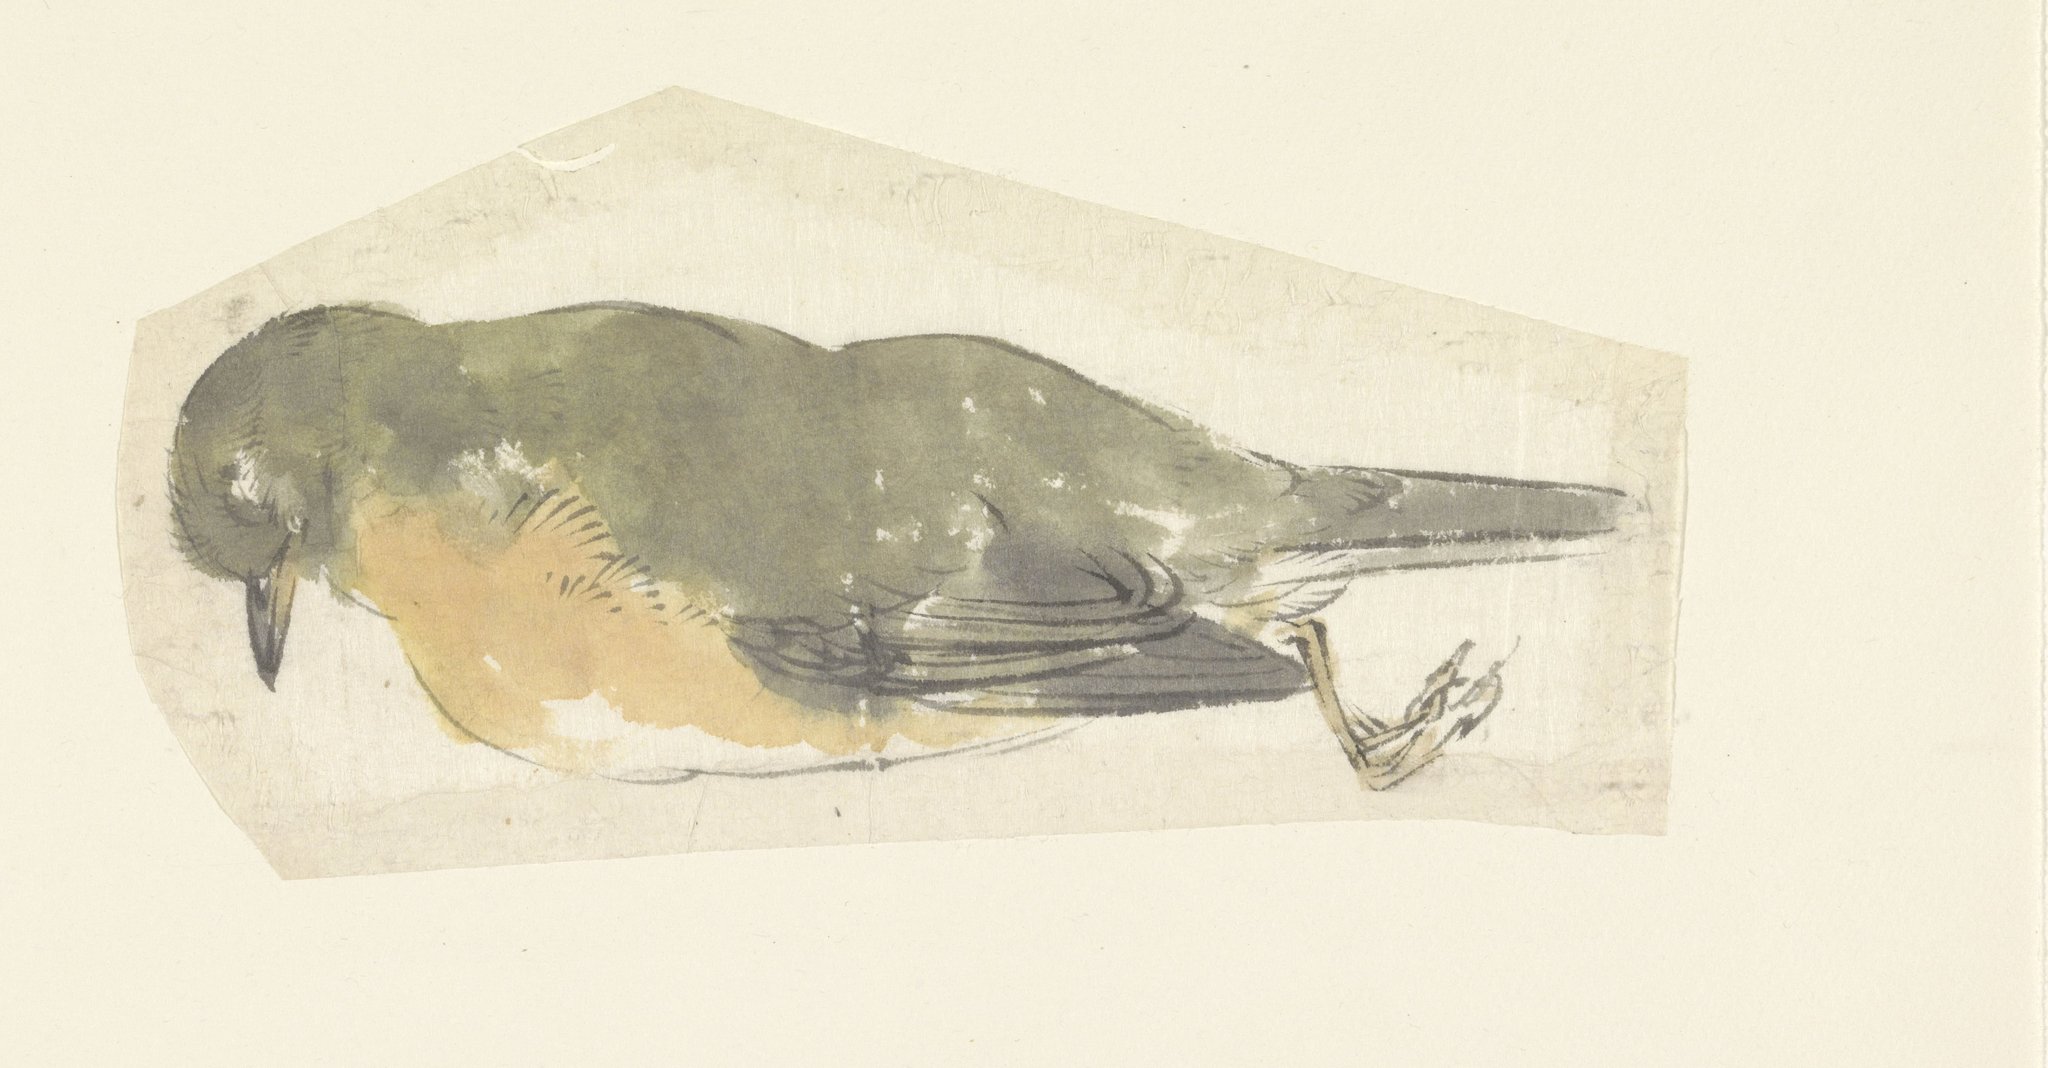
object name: watercolor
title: Dode roodborst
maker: yamamoto shinryo baiitsu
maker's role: draughtsman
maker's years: 1789-1857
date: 1800-1900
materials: paper, watercolor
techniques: brush